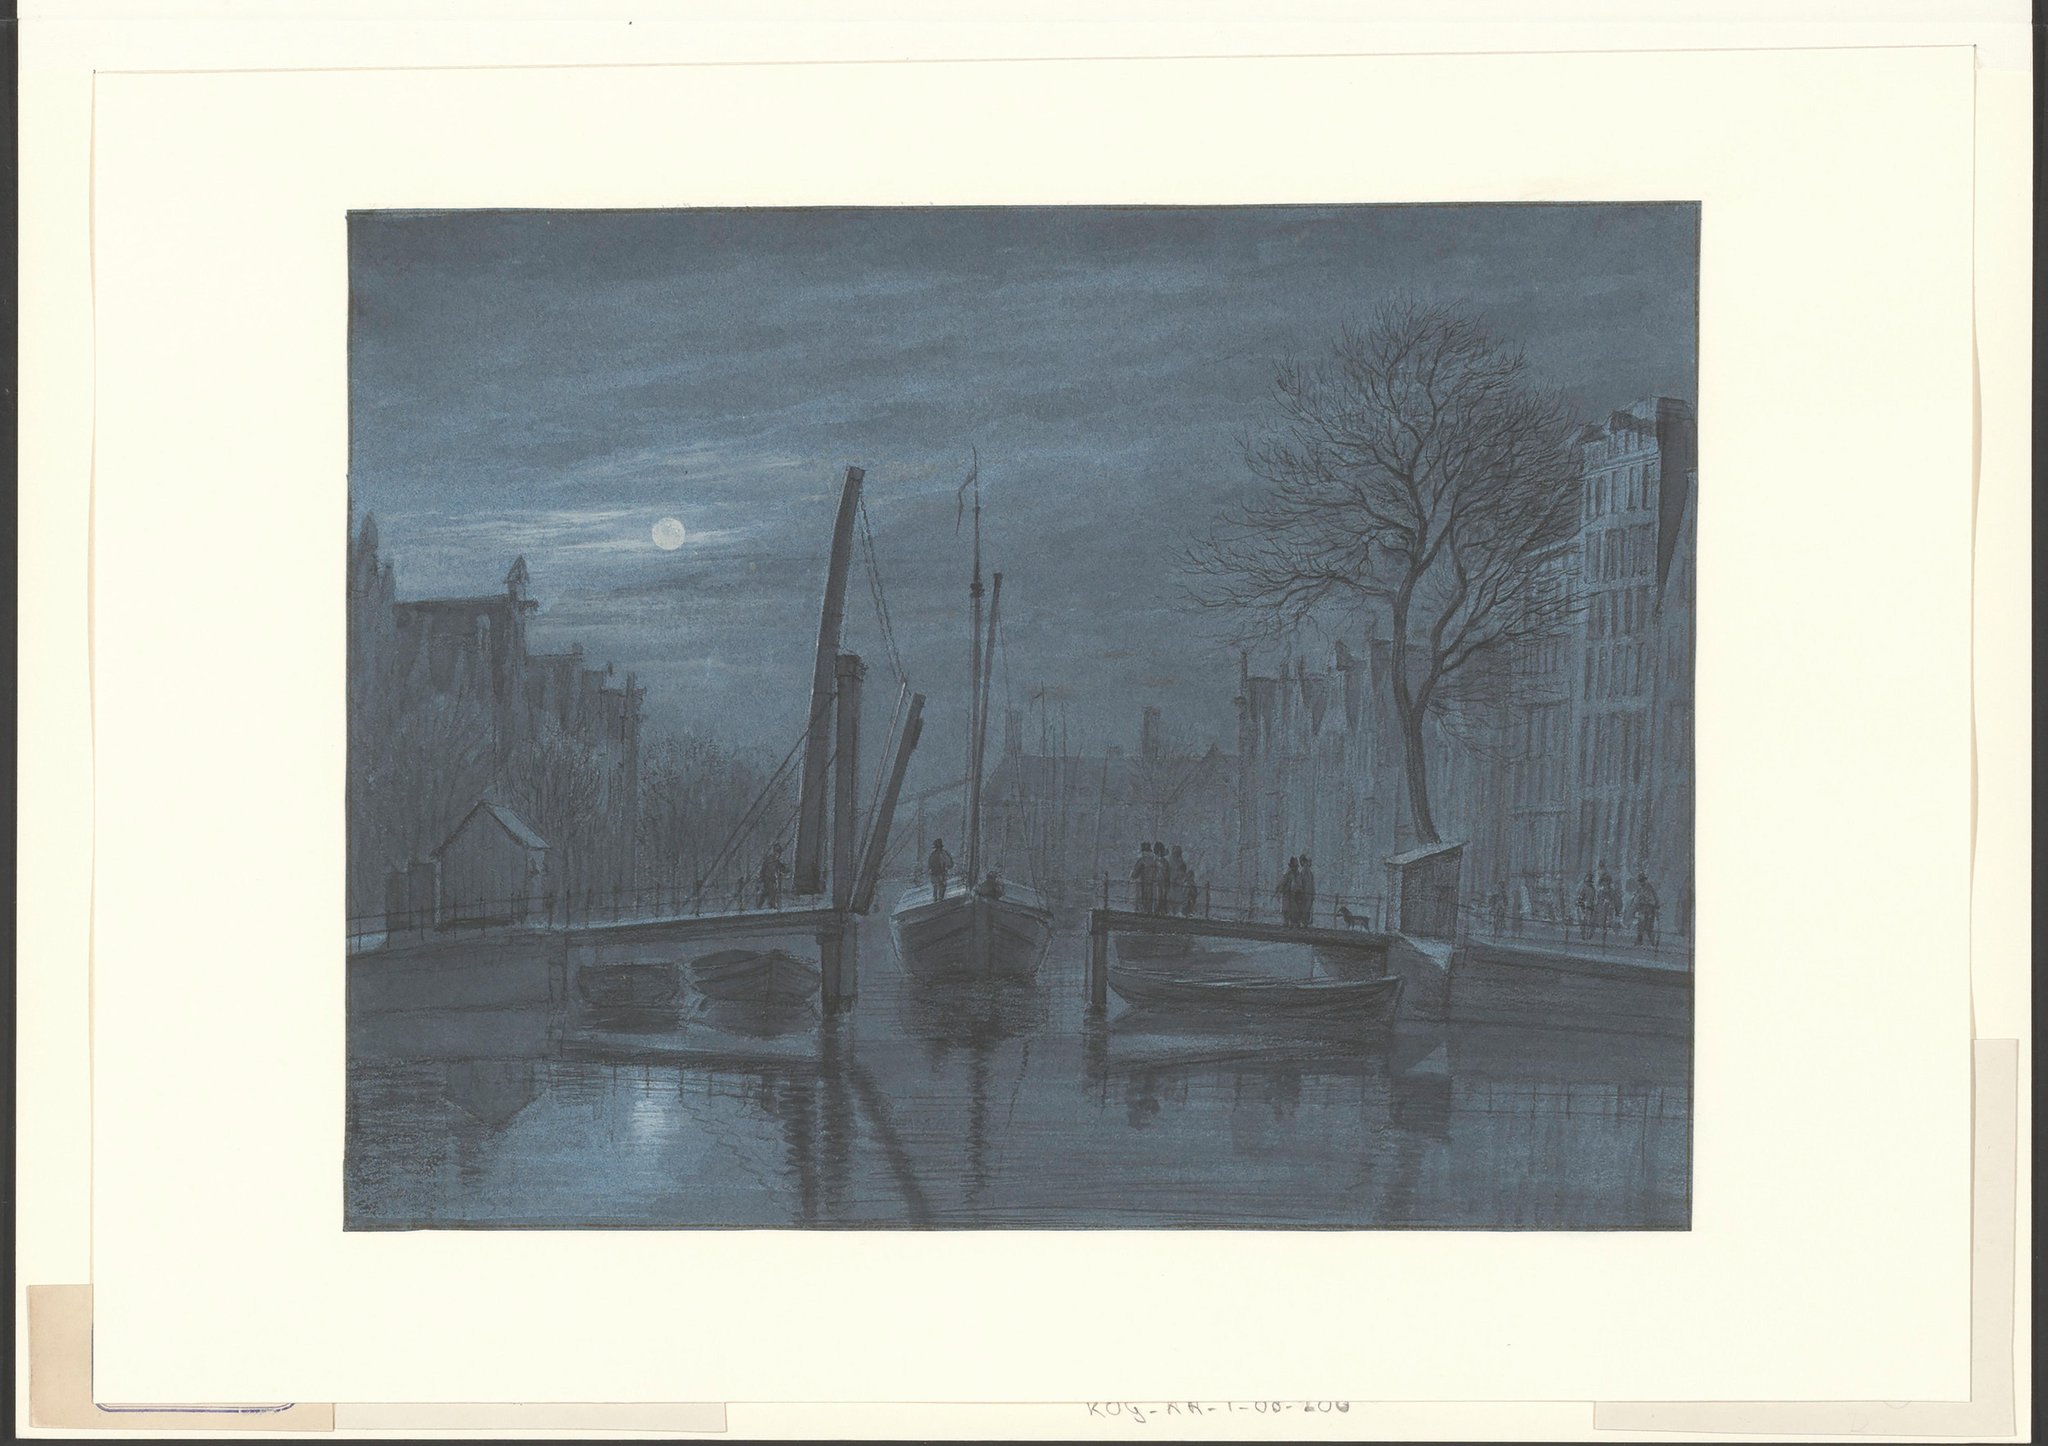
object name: drawing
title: Gezicht op de Houtgracht, gezien vanaf de Zwanenburgwal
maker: jan van ravenswaay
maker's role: draughtsman, painter, print maker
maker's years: 1789-1869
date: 1799-1869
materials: chalk, paper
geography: amsterdam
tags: sailing-ship, sailing-boat, city-view in general; 'veduta', canal, bridge in city across river, canal, etc.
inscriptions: inscription: ‘Houtgracht / Geschenk v/d heer / Koch sept 1882 / Ravenswaay del.’, collector's mark: ‘8’ Lugt 1641b, inscription: ‘Port. 8-200’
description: Onderwerpsrubriek binnen de Atlas Amsterdam: Heerengracht (Nieuwe), Heiligeweg, Heisteeg, Heintjehoeksteeg, Hekelveld, Hemelrijk, Hoedemakerspad, Hol (‘t), Houtgracht, Houtewaelerboom, Houtkoopersdwarsstraat, Houttuinen (Joden), Houttuinen (Haarlemmer), Hugo de Grootkade, Huidenstraat, Huidenvetterstraat, Huydecoperstraat.